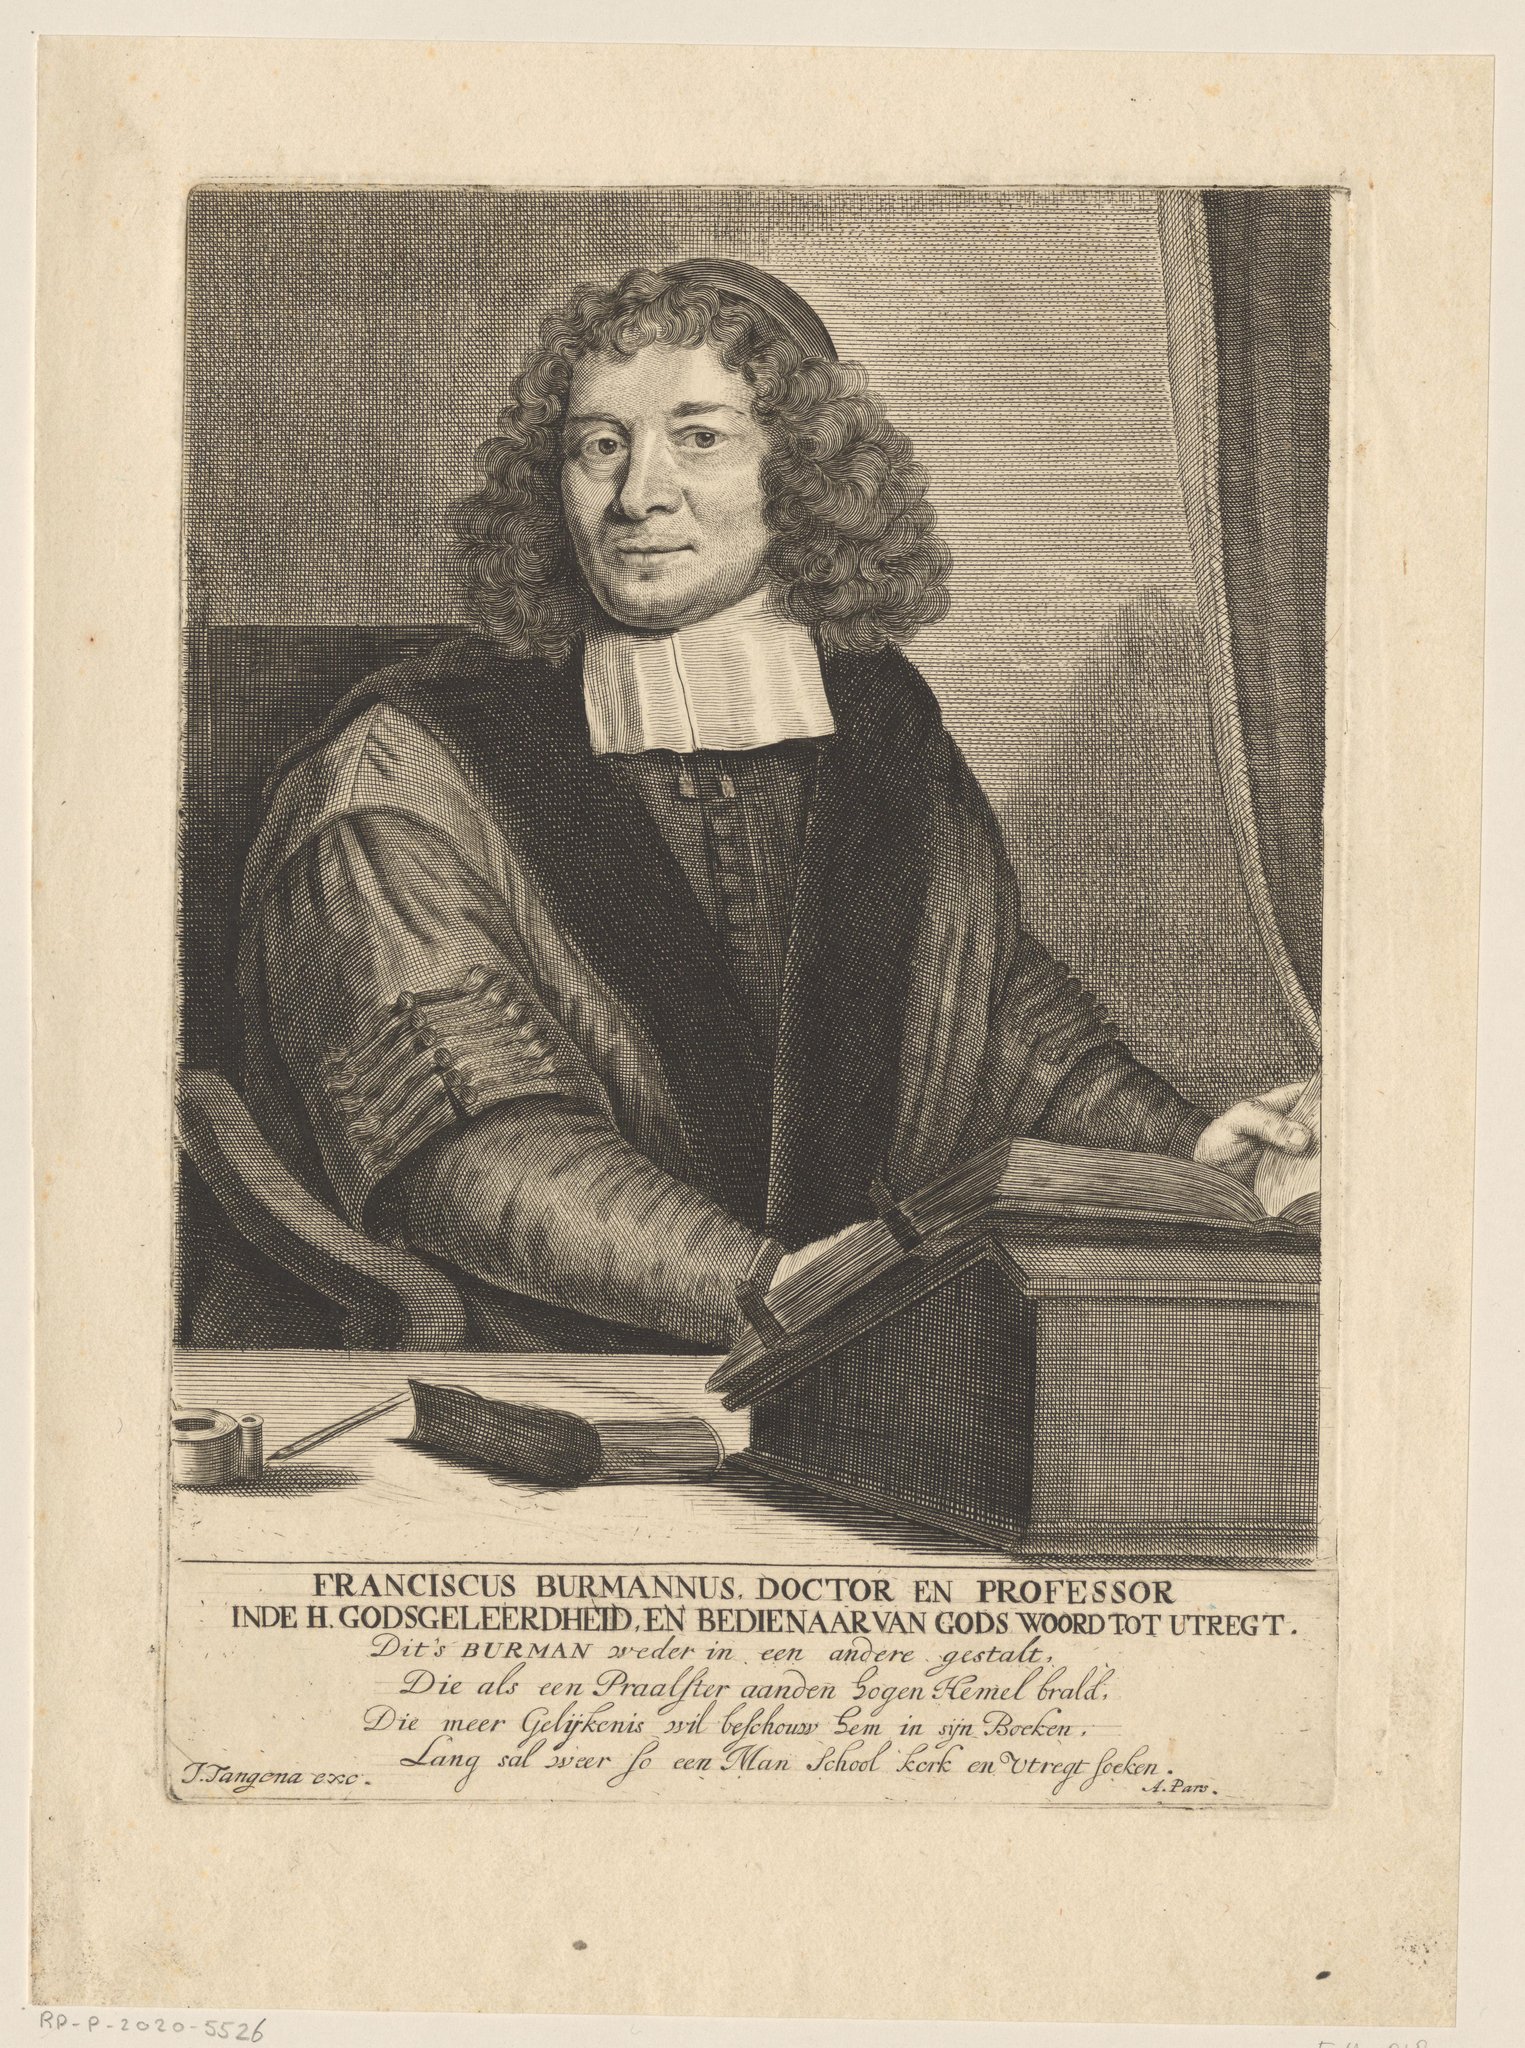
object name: print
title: Portret van Frans Burman (I)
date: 1687-1691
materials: paper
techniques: engraving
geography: leiden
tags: leiden, utrecht, scholar, philosopher, historical persons, book